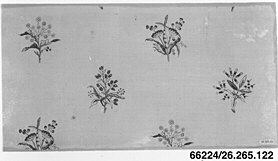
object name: floral print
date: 1785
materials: linen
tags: flowers